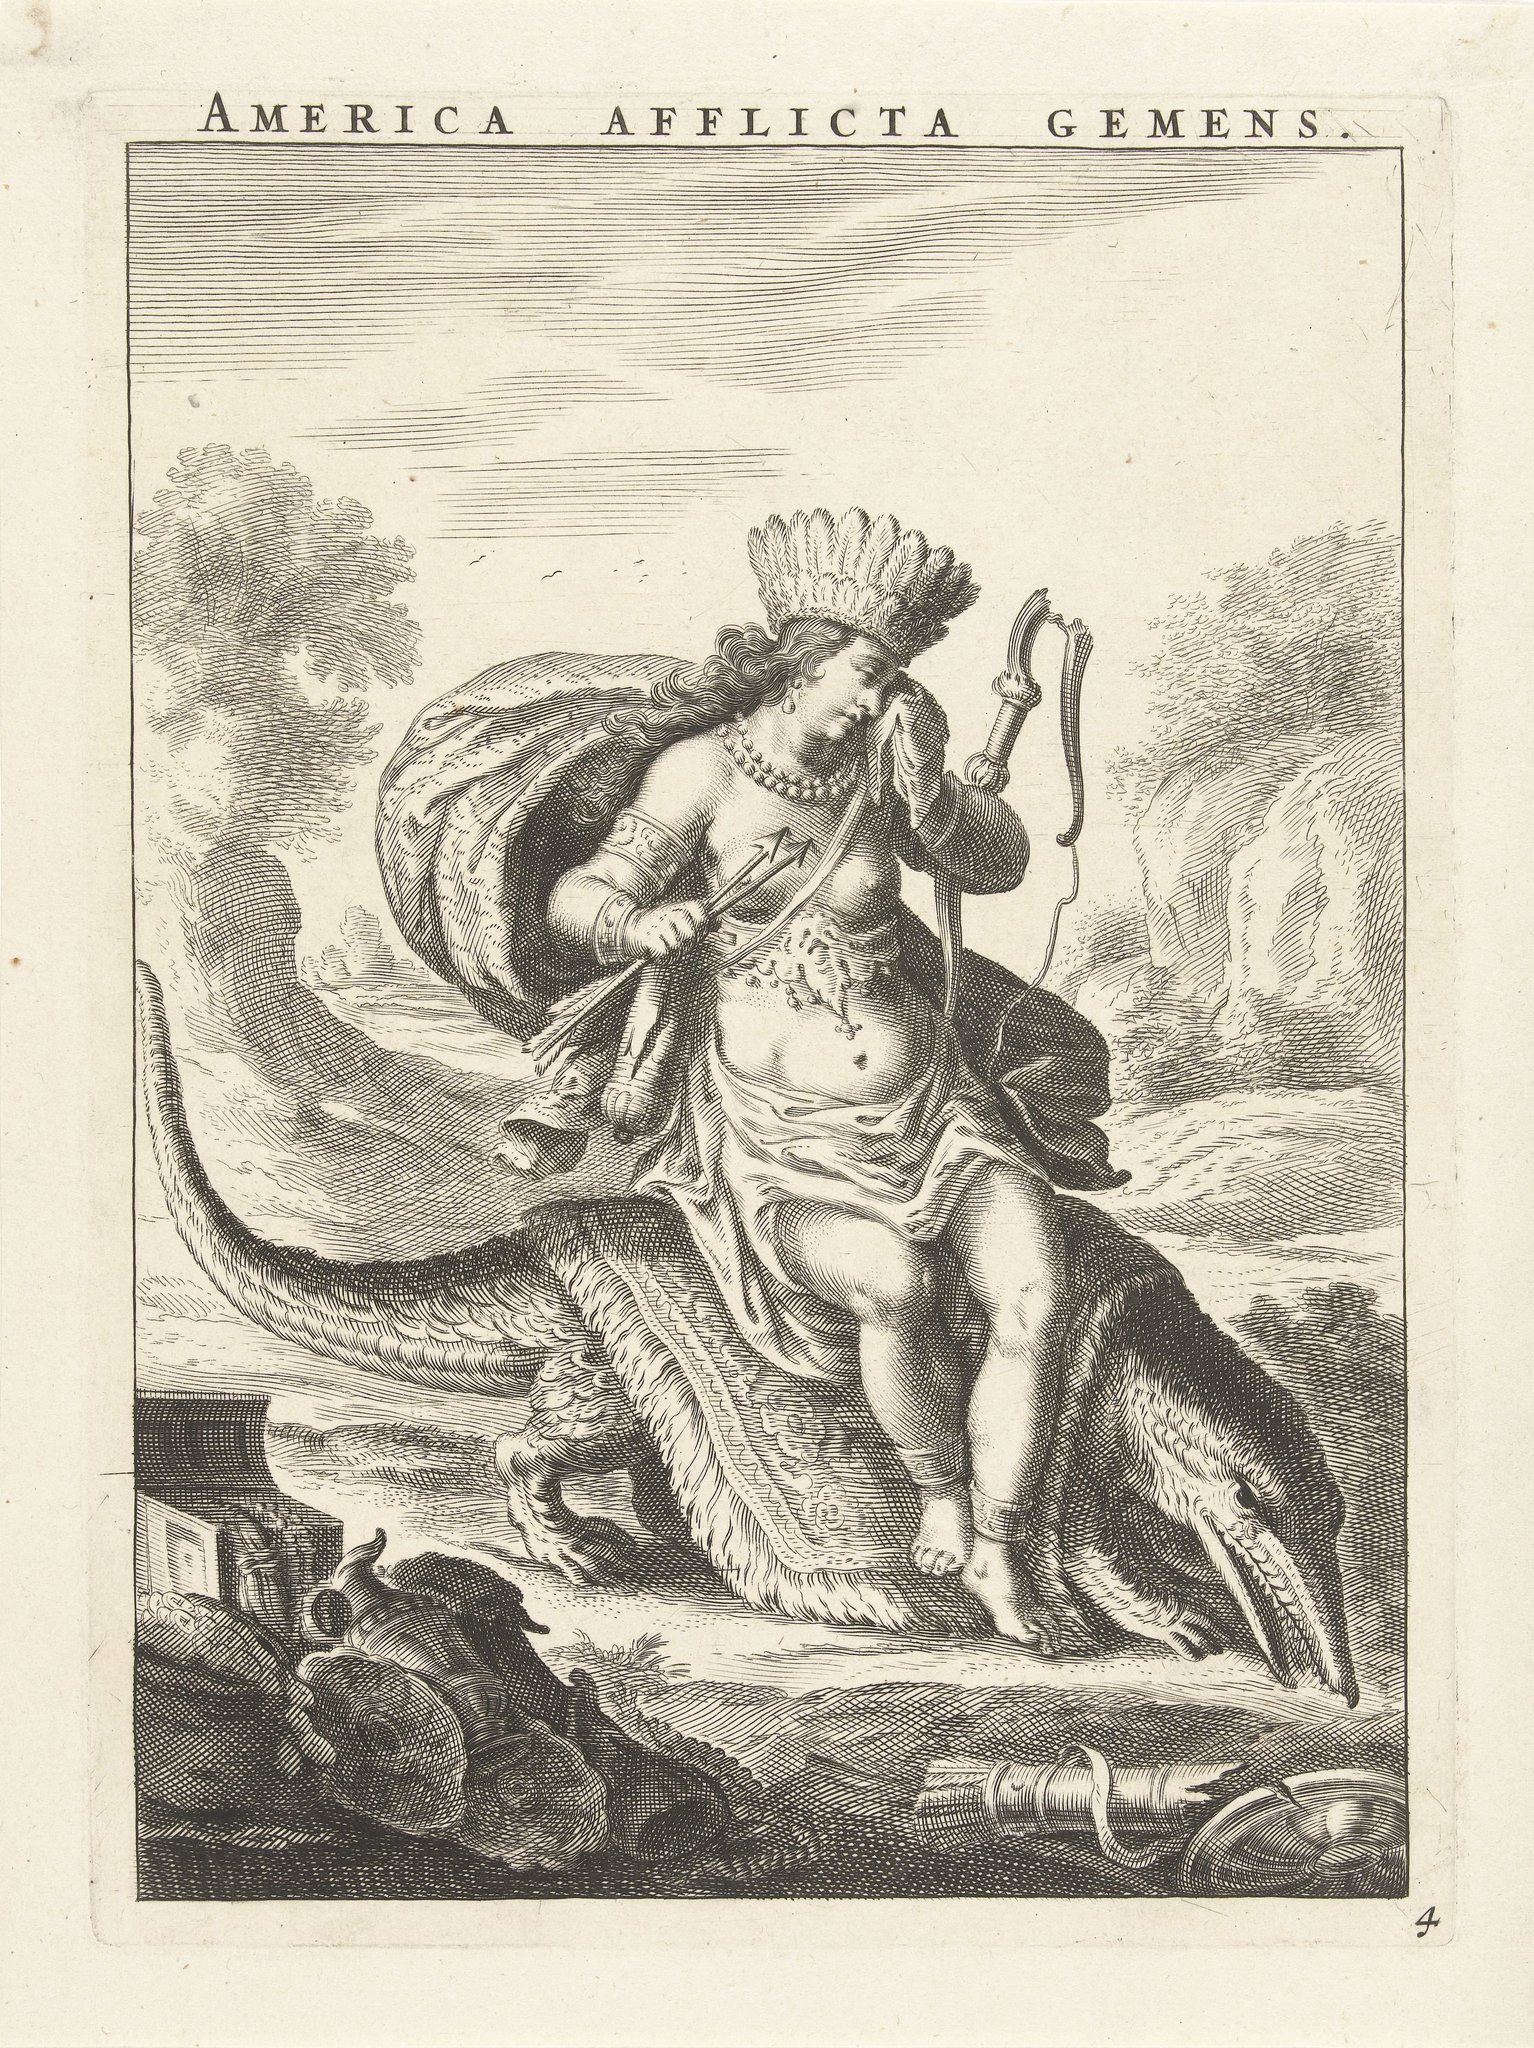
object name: print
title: Vier werelddelen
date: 1648-1664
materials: paper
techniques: engraving, etching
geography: amsterdam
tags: america represented allegorically; 'america' (ripa), owls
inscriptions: collector's mark: Lugt 2228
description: Vrouwelijke personificatie van Amerika als vrouw met hoofdtooi van veren en pijl en boog zittend op kaaiman of krokodil. Zij droogt haar tranen en rouwt aldus de titel.